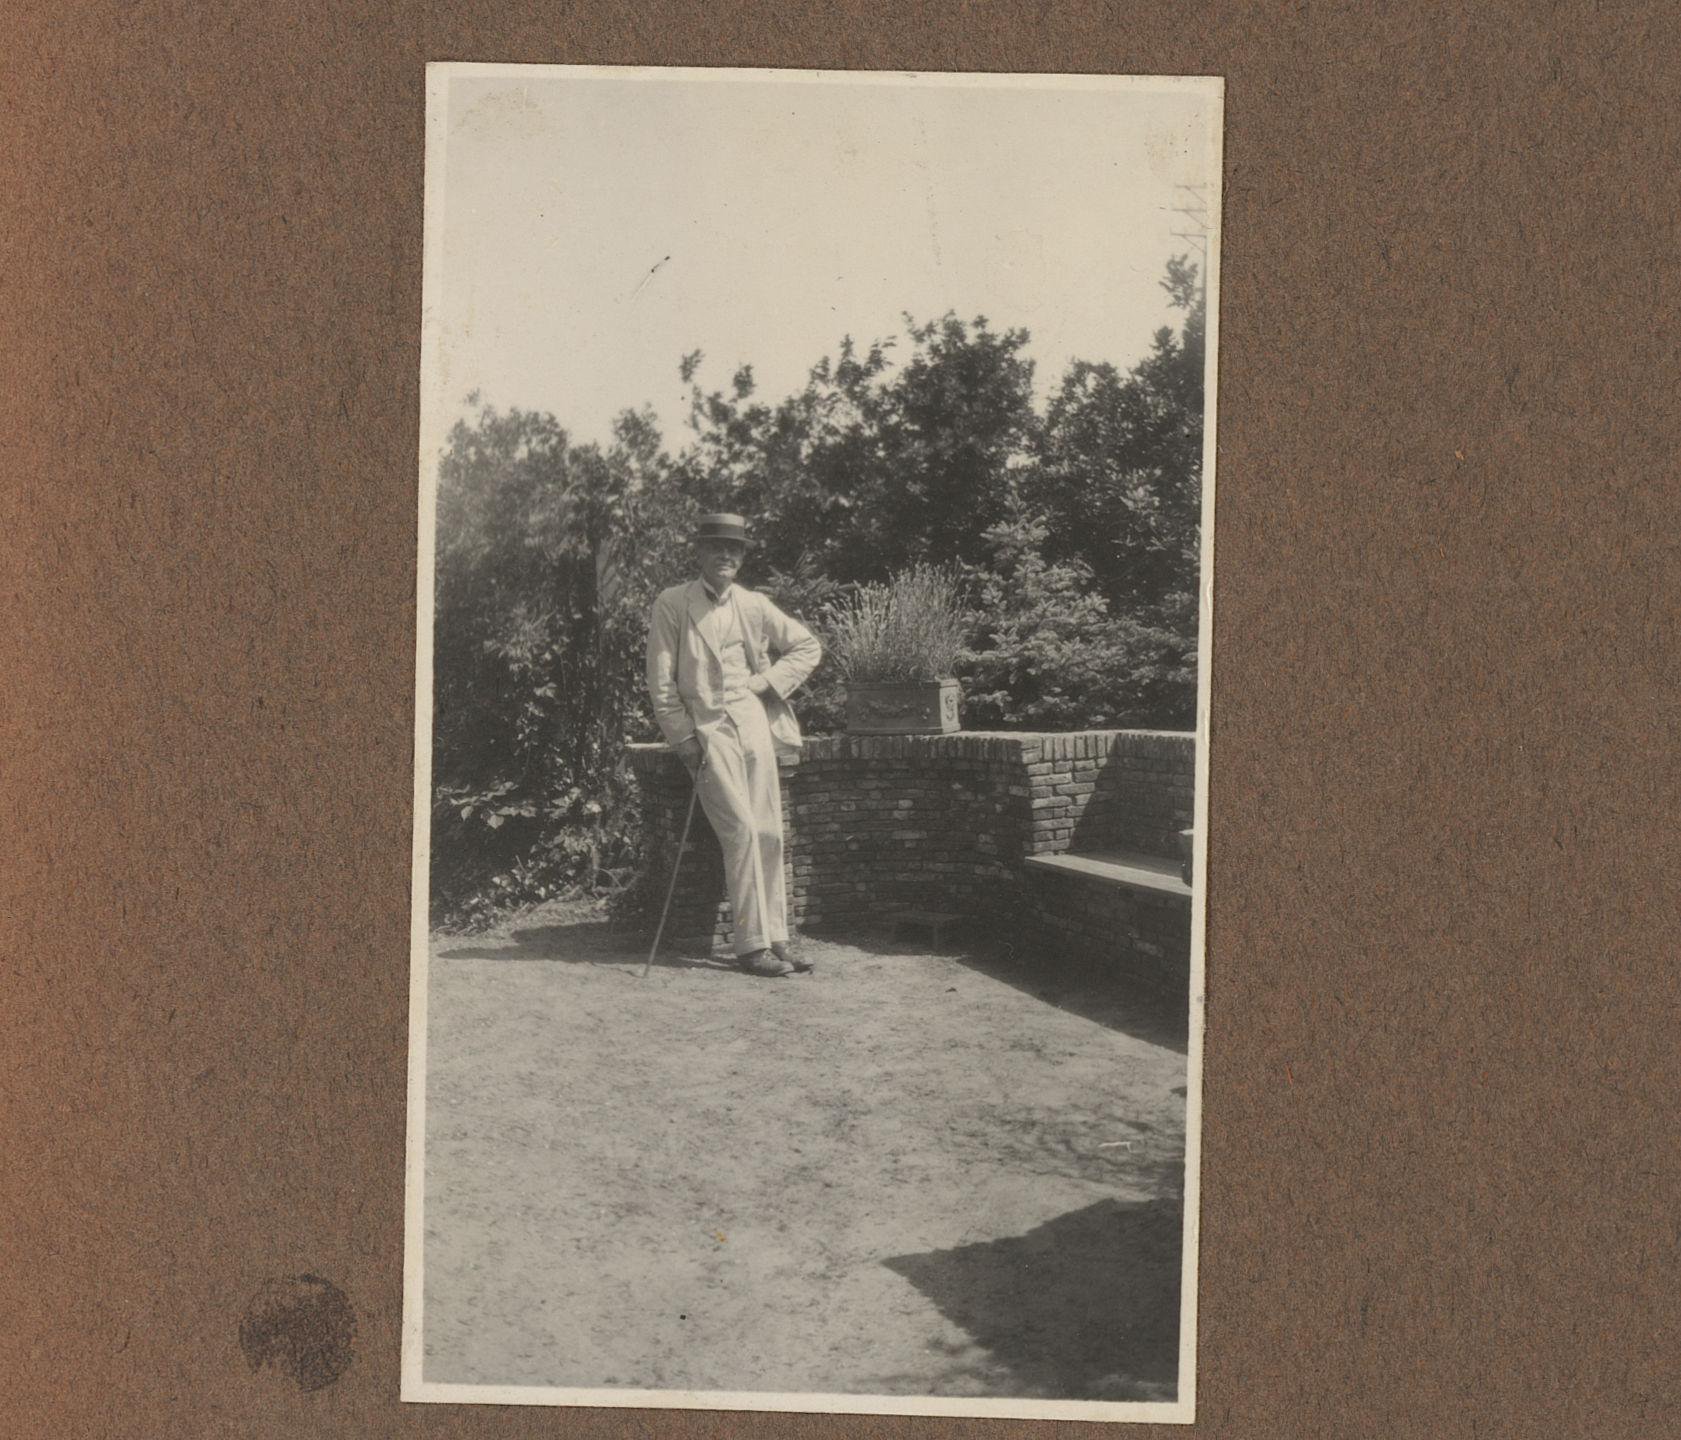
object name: photograph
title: Alphons Diepenbrock, staand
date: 1900-1915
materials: photographic support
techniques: photography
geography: netherlands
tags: alphons diepenbrock, netherlands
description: Foto op bruin albumblad 52 van familiealbum van Alphons Diepenbrock.